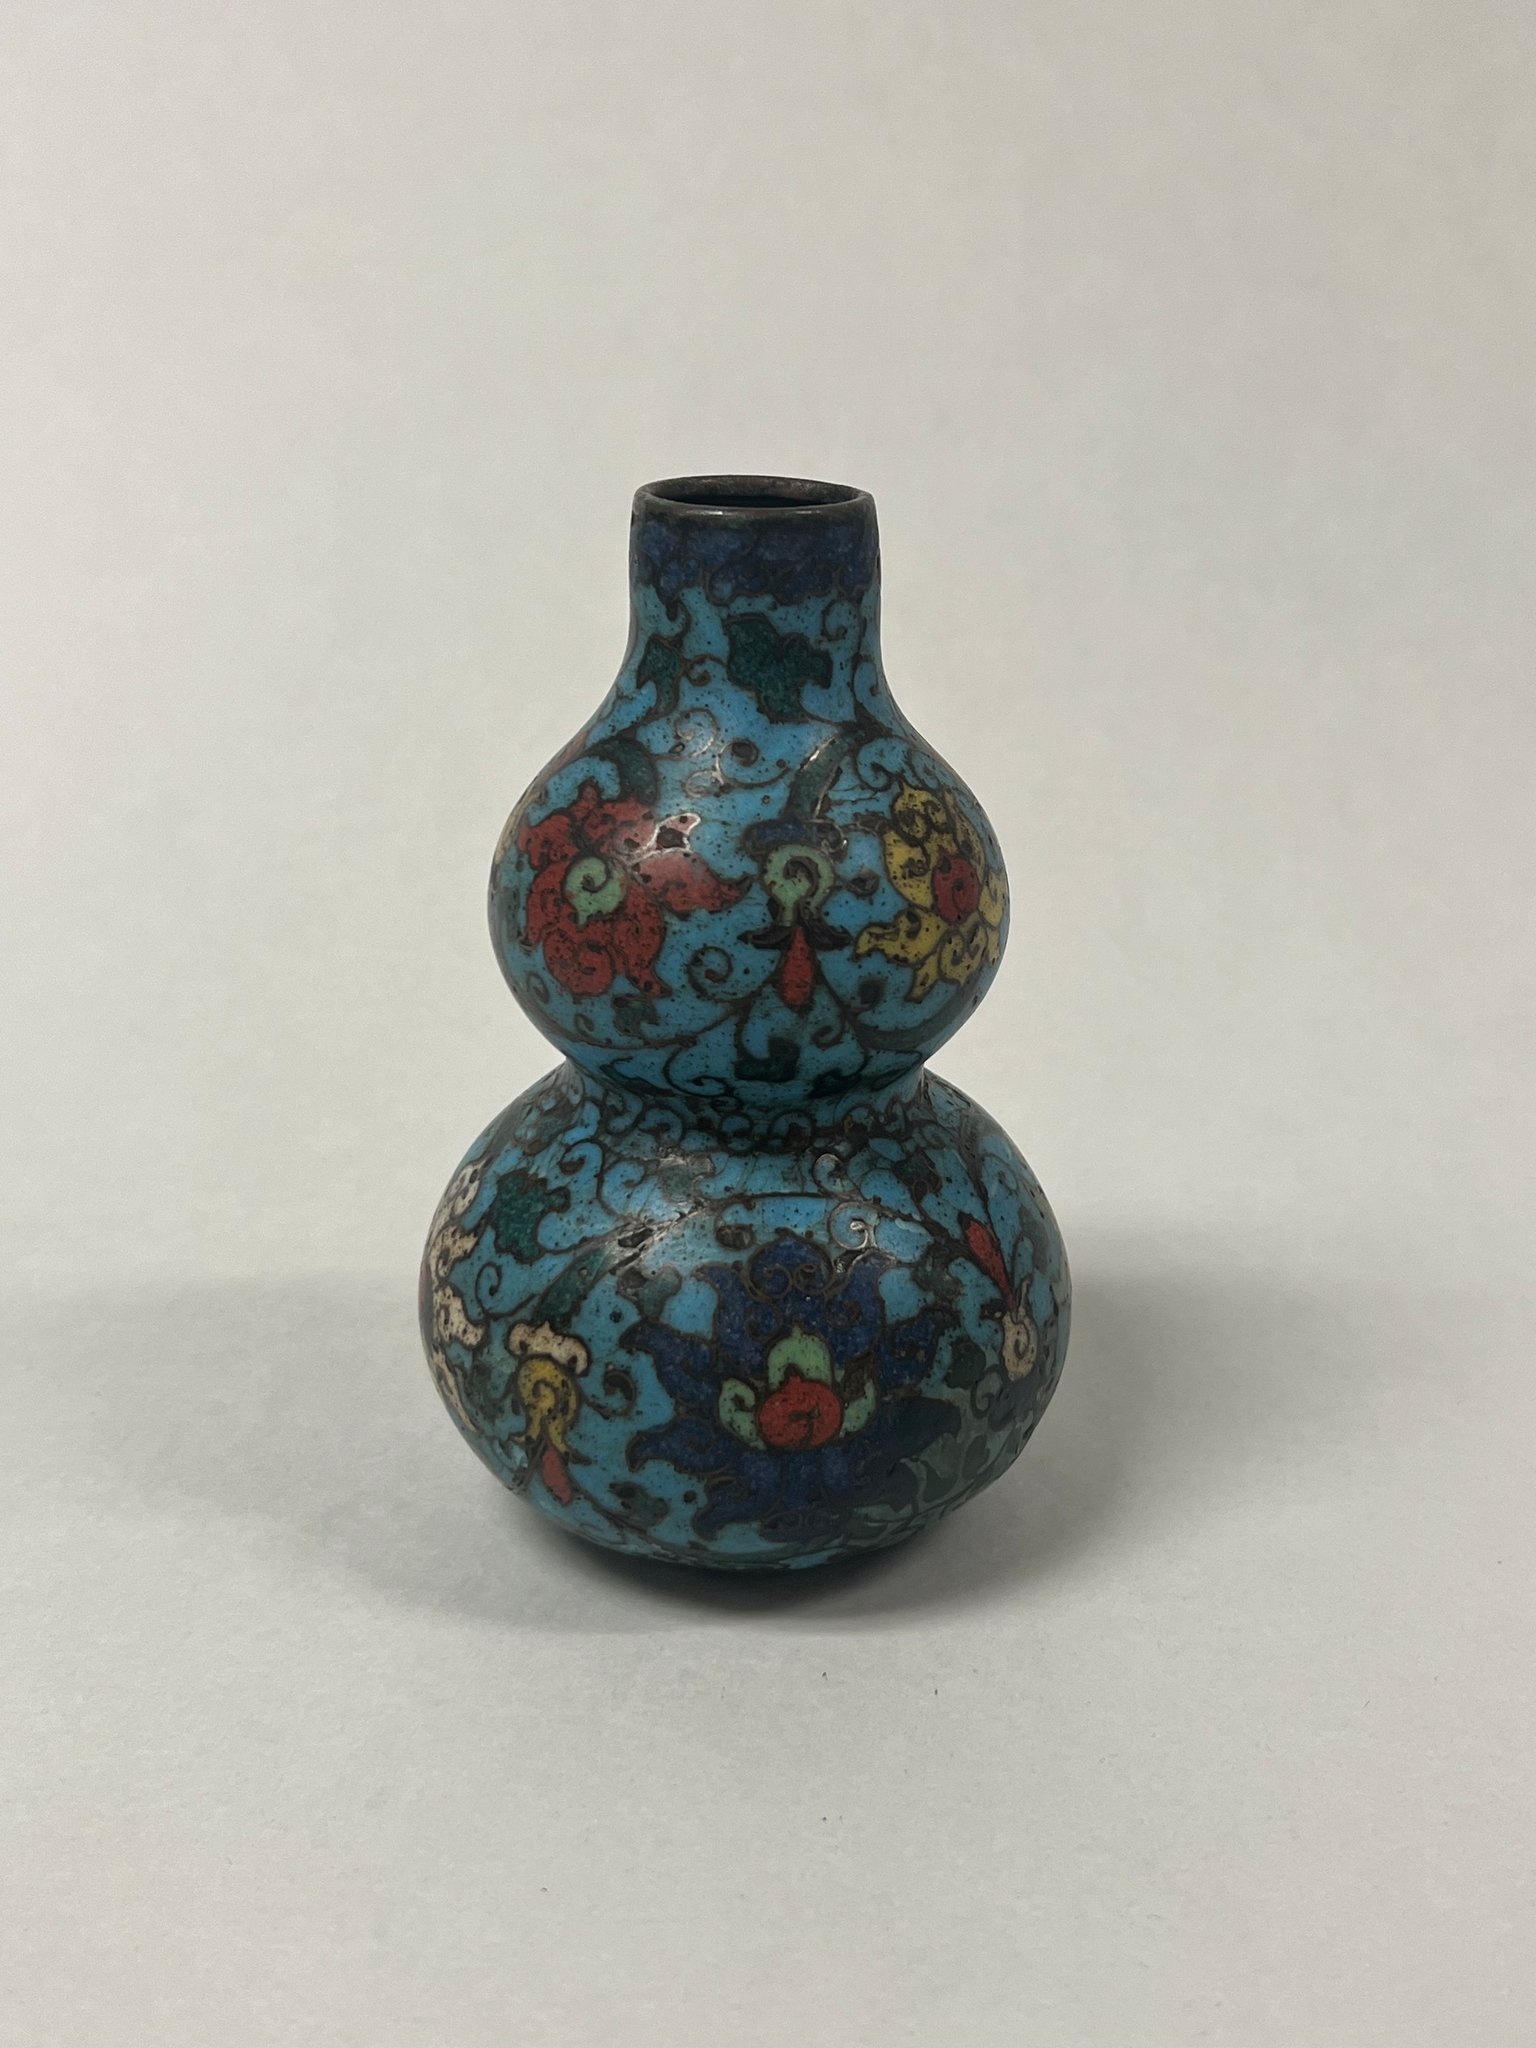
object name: vase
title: Gourd-Shaped Vase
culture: chinese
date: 1501-1600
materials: enamel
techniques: enamel